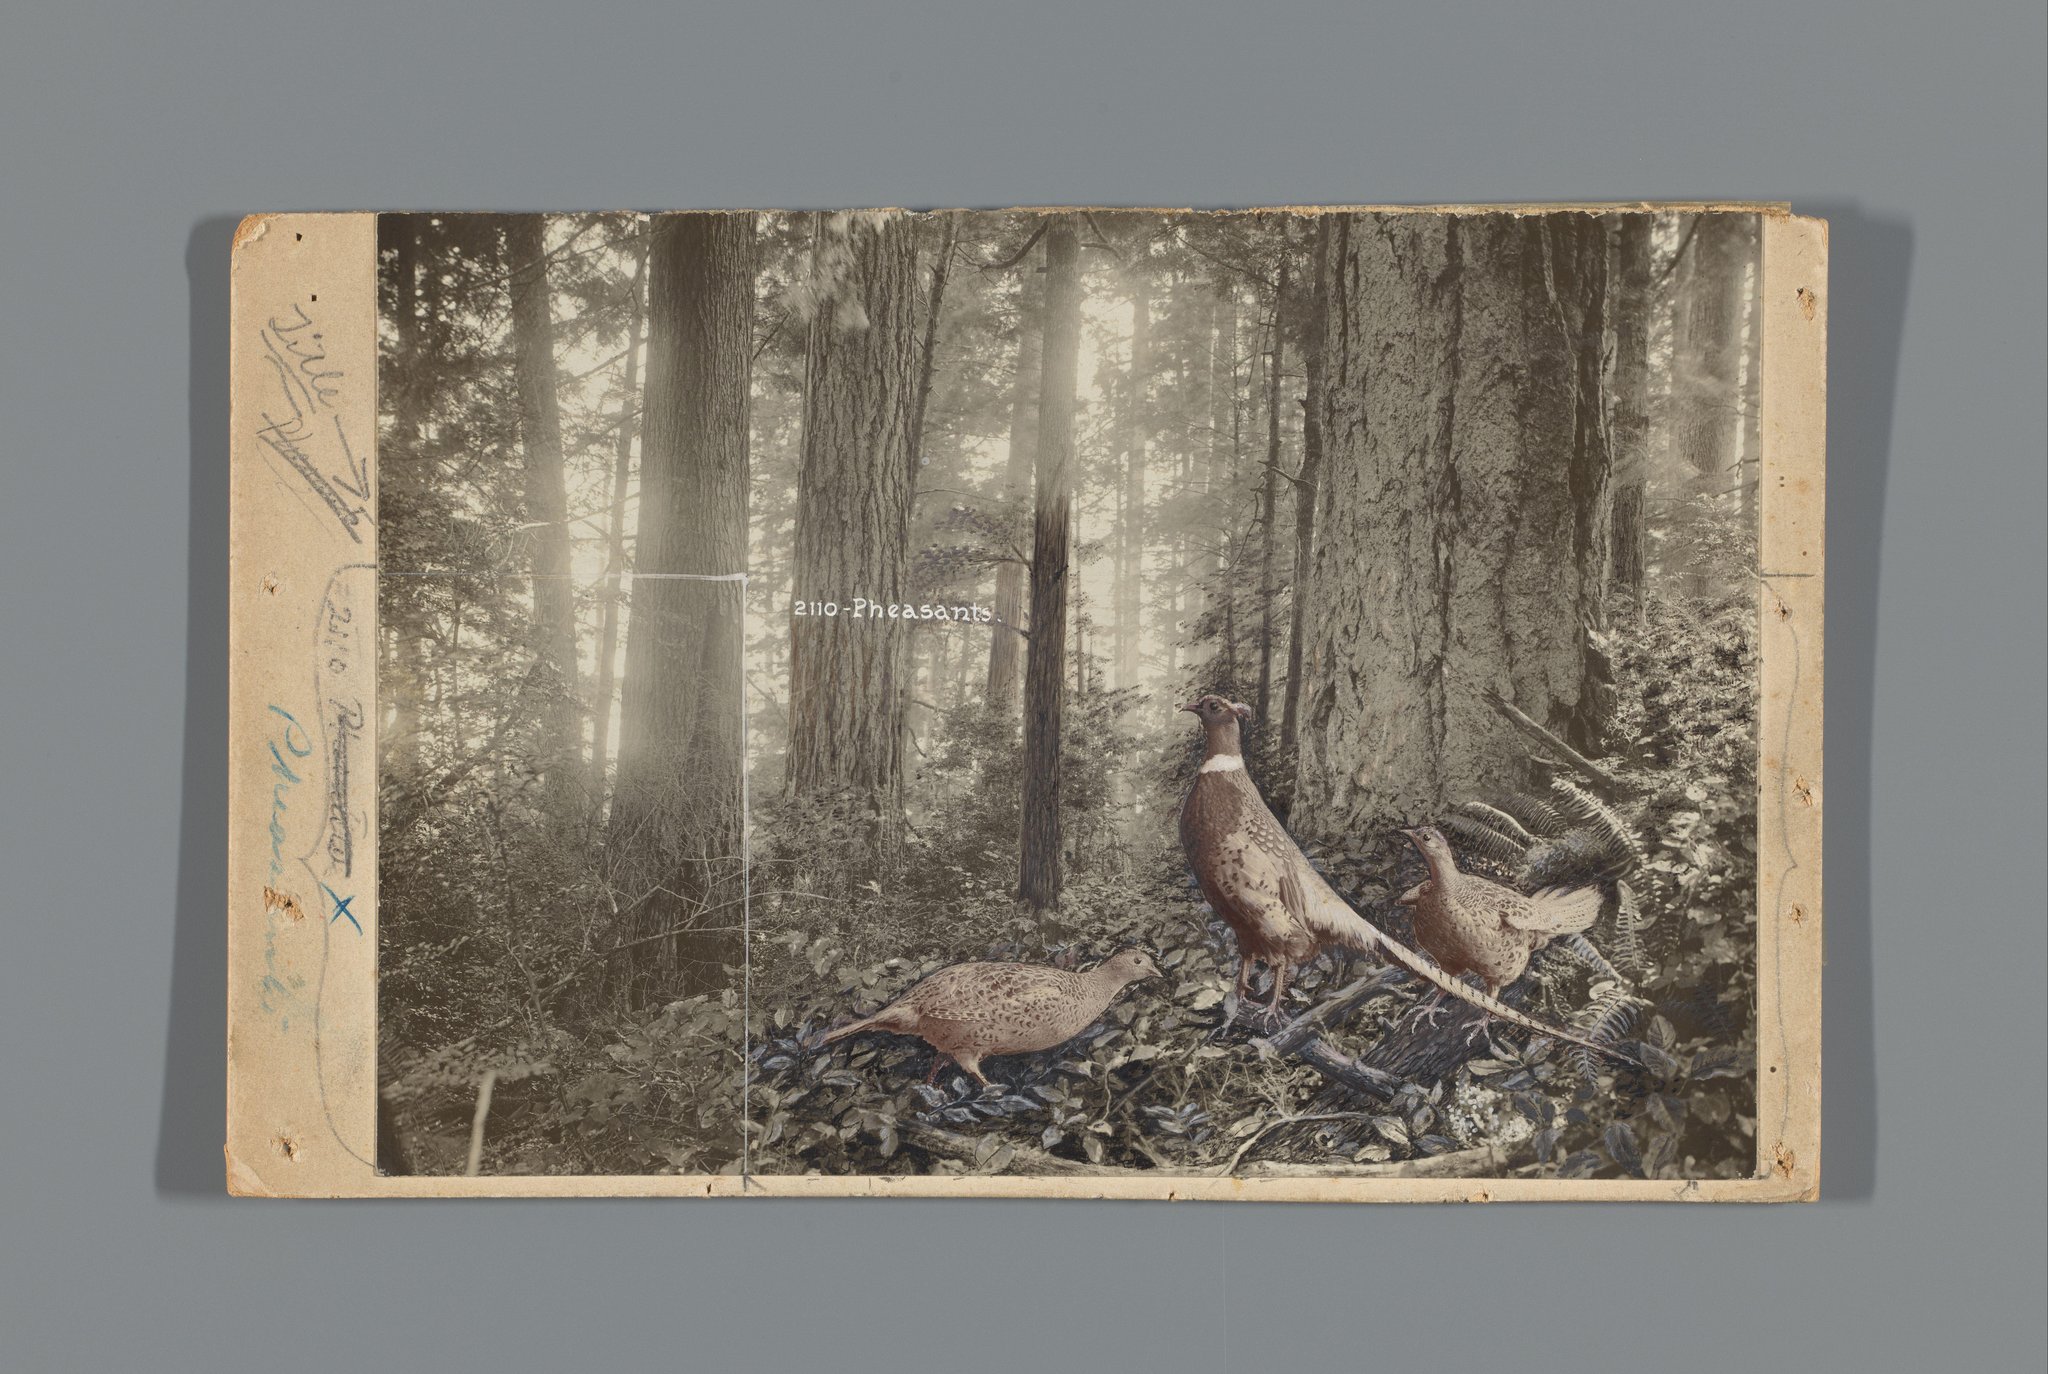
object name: photograph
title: Bosgezicht met fazanten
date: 1910-1930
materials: ink, paint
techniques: gelatin silver print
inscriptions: annotation: ‘2110 – Pheasants’, annotation: ‘moeilijk leesbare tekst’, annotation: ‘Title 2110 pheasants’, annotation: ‘Souvenir Publishing Co.’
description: Opgewerkte foto, met in de marge aanwijzingen voor de opmaak.